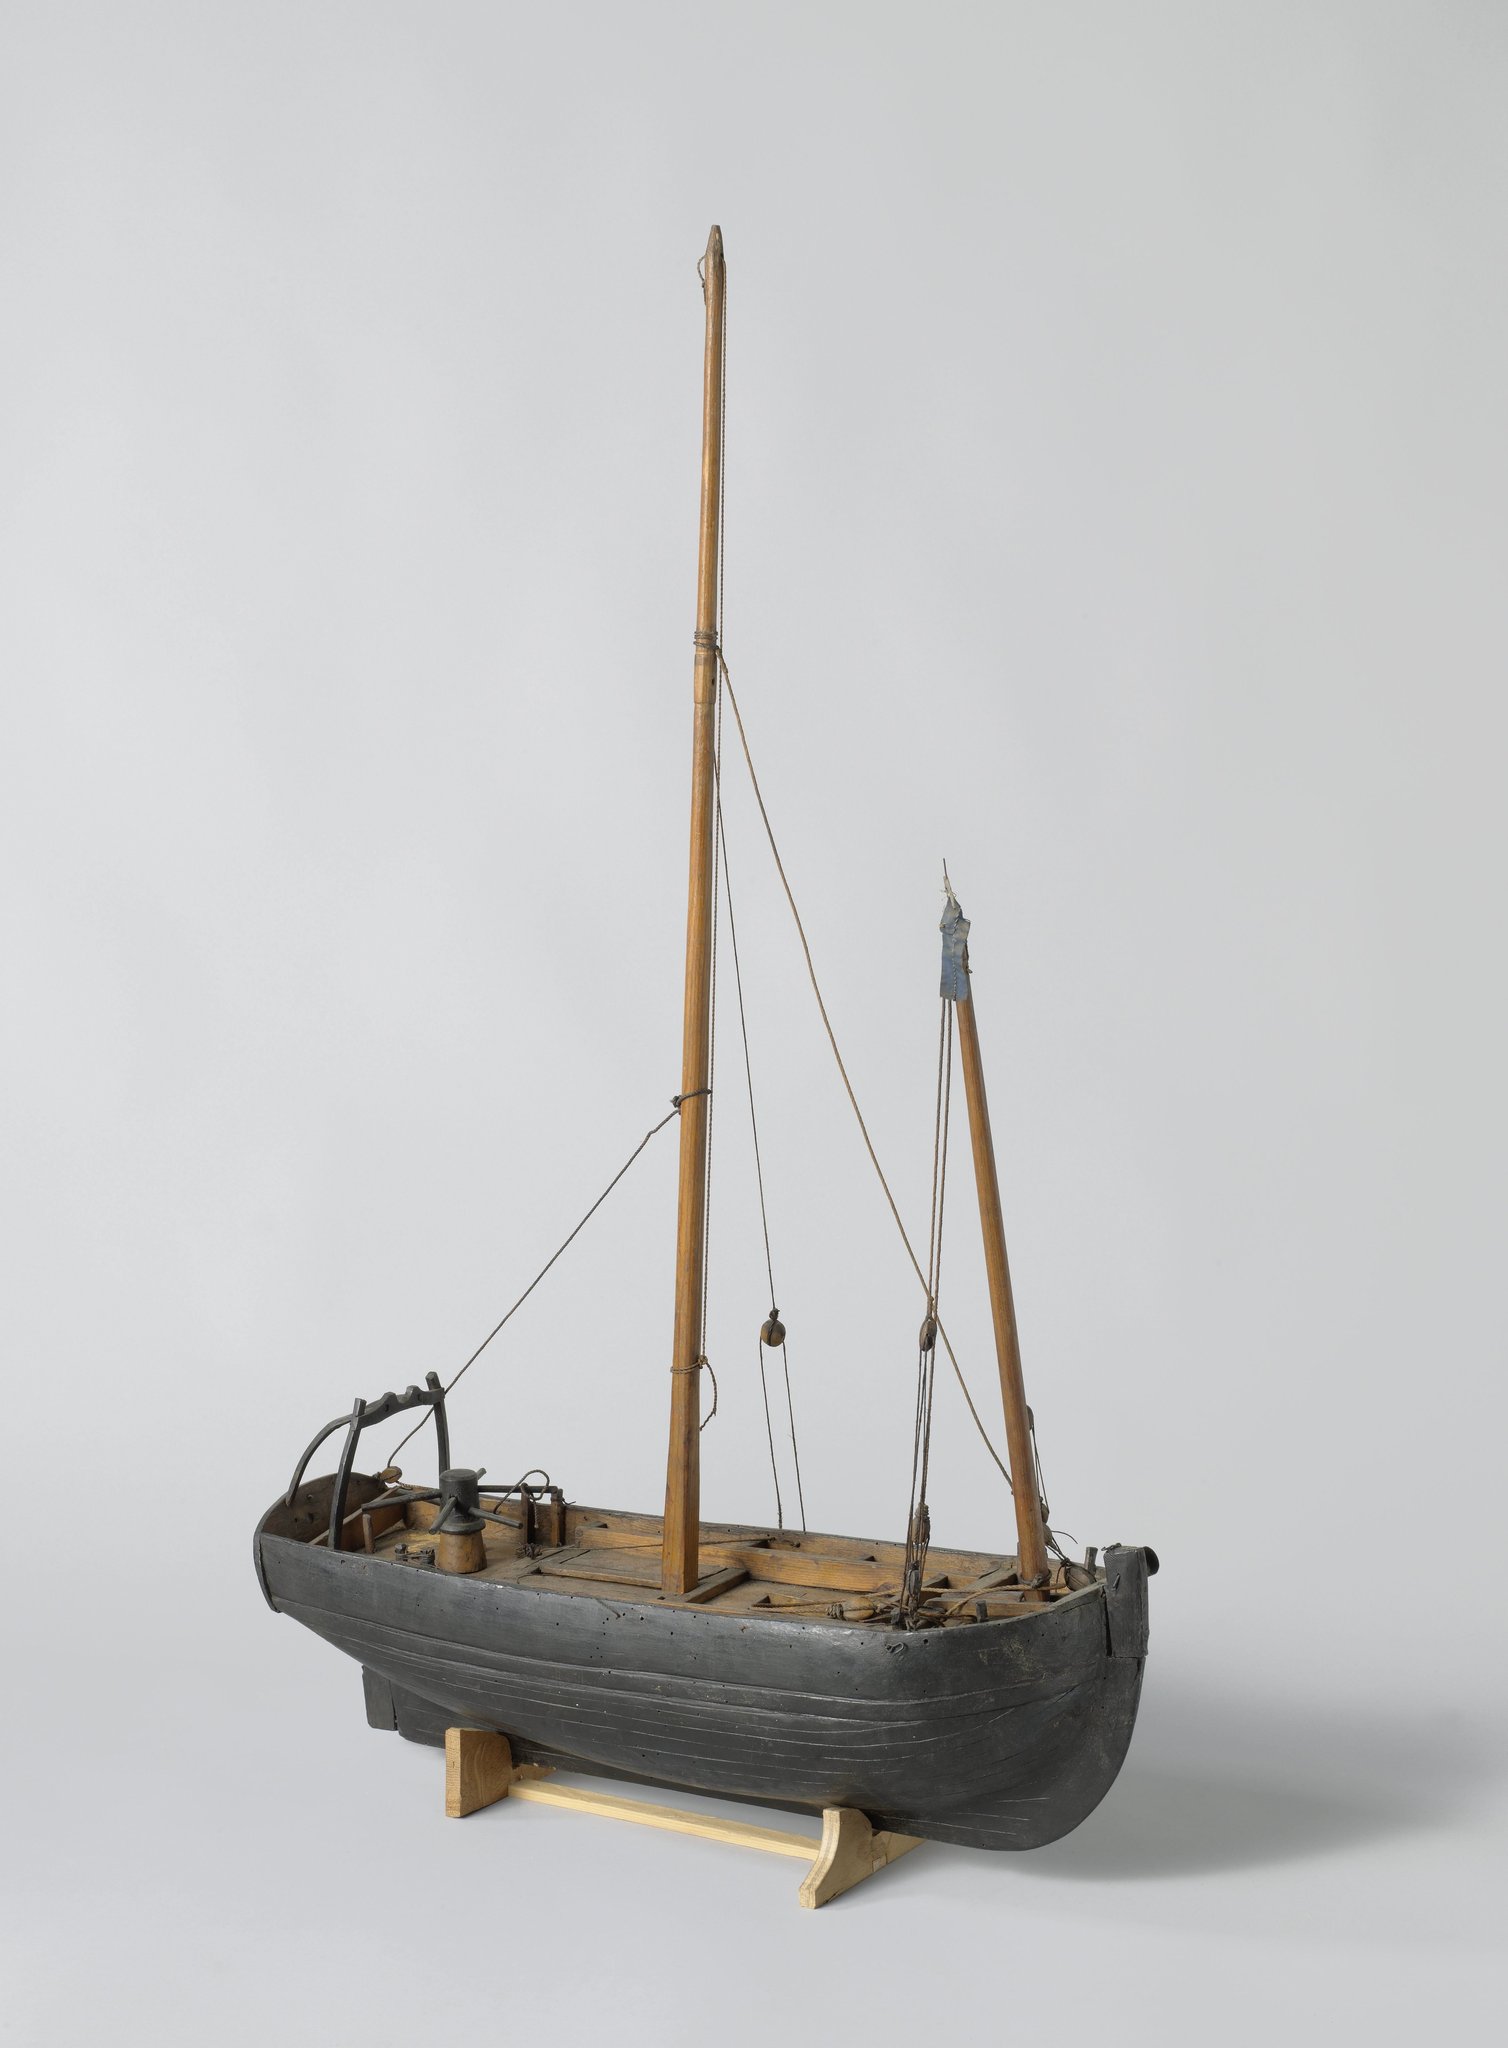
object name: ship model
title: Model of a French Lugger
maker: Anonymous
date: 1850-1870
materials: fiber, wood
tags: france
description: Model van een Franse logger. Op voetstuk.